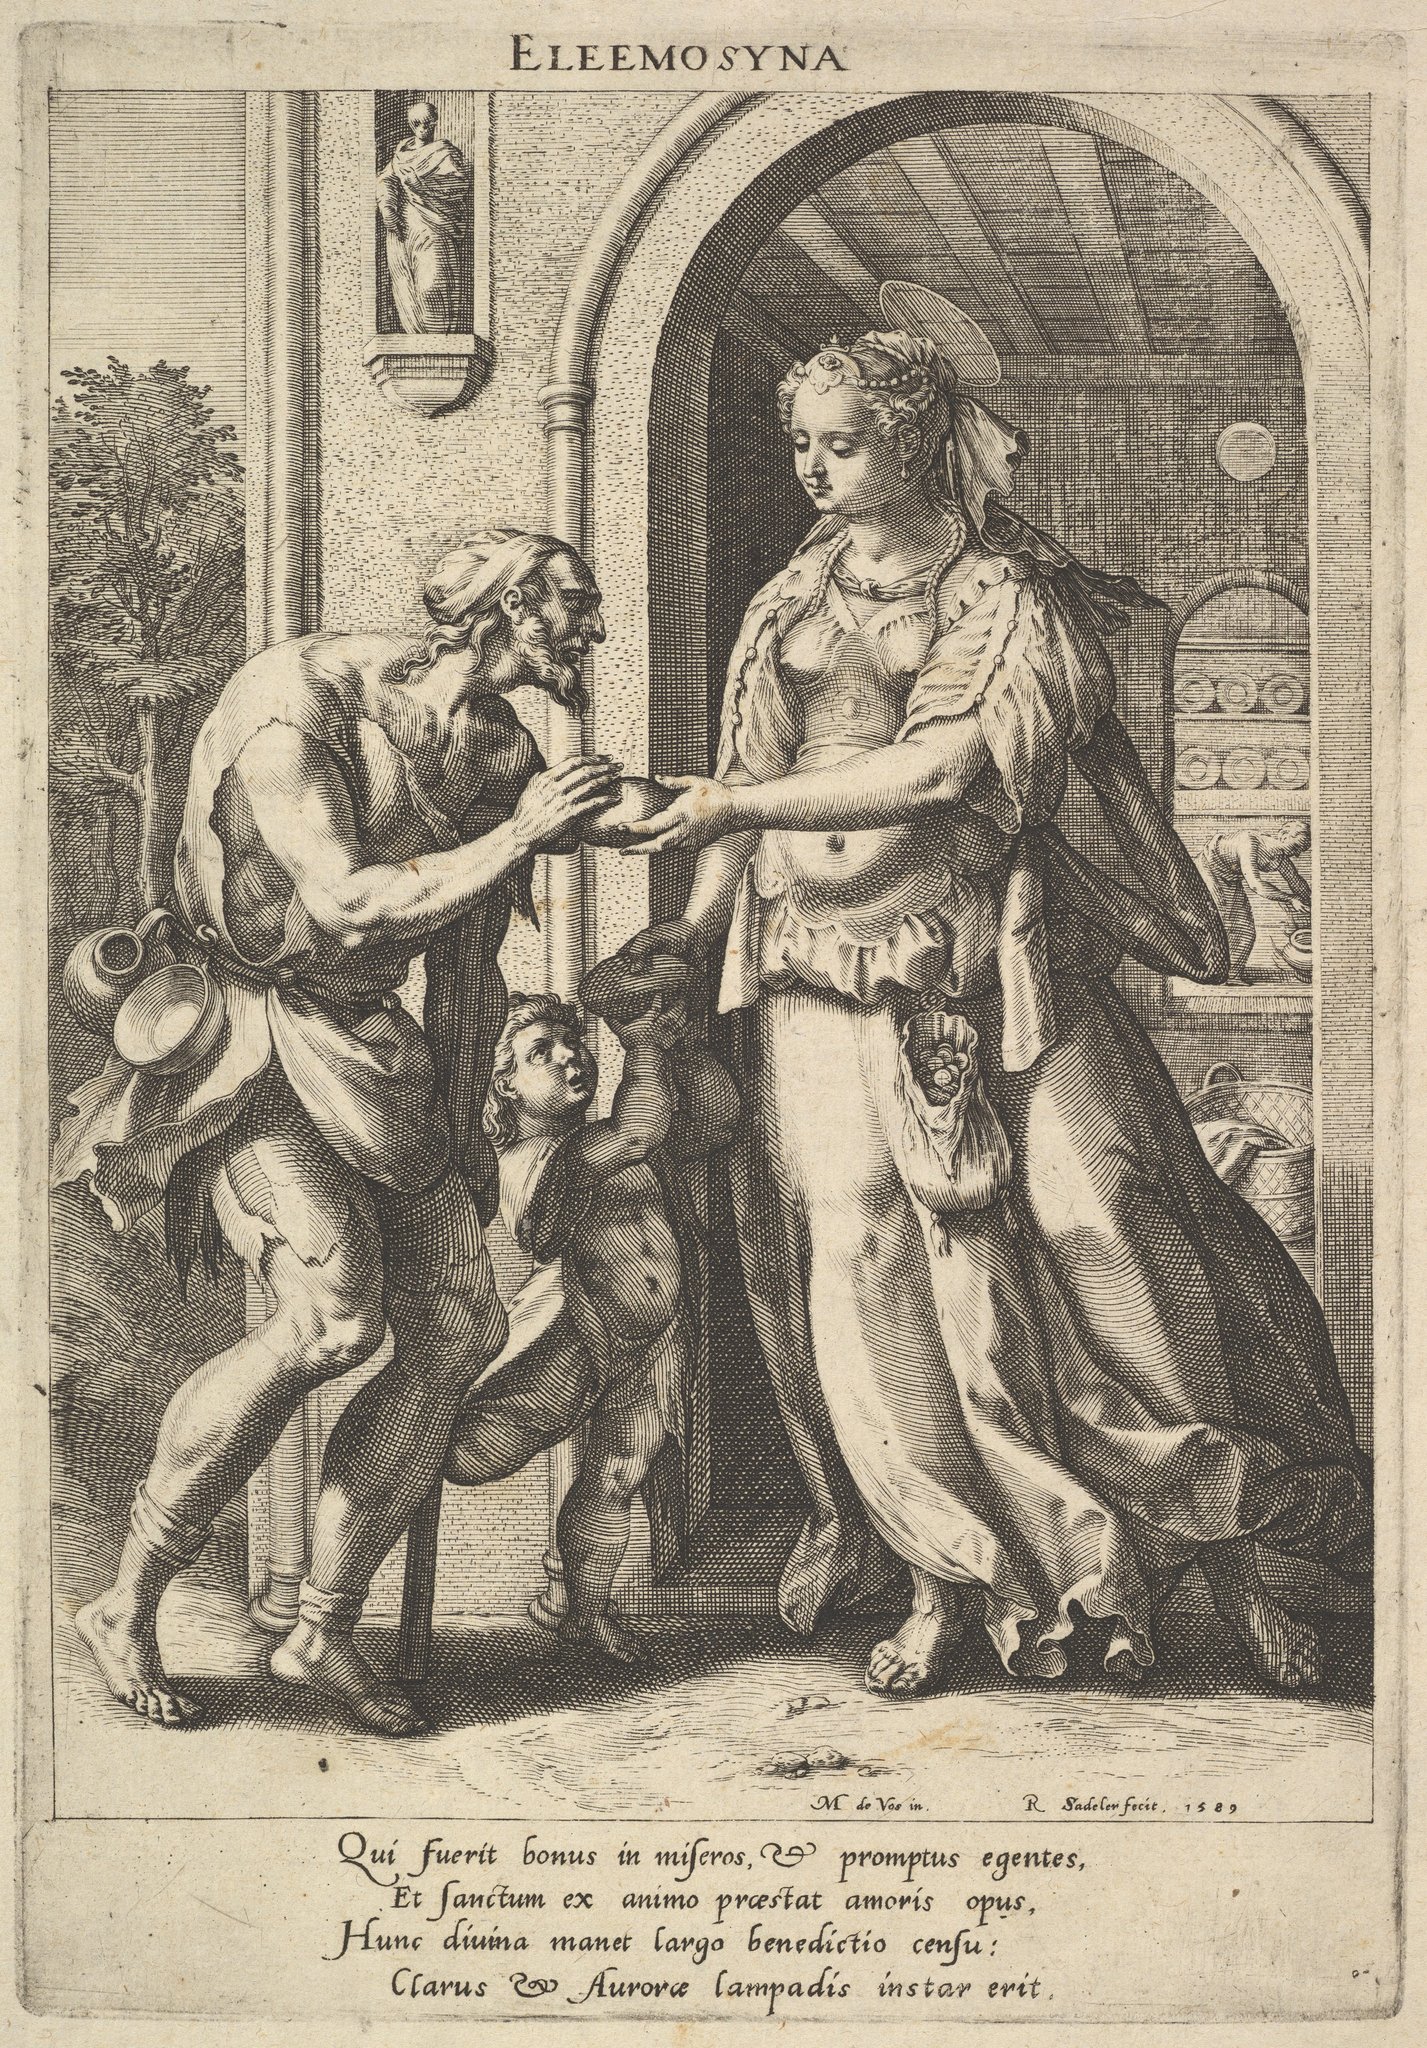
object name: print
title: Alms-giving, from "Christian Virtues"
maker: raphael sadeler i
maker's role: artist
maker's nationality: netherlandish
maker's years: 1560-1628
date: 1589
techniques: engraving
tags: boys,men,women